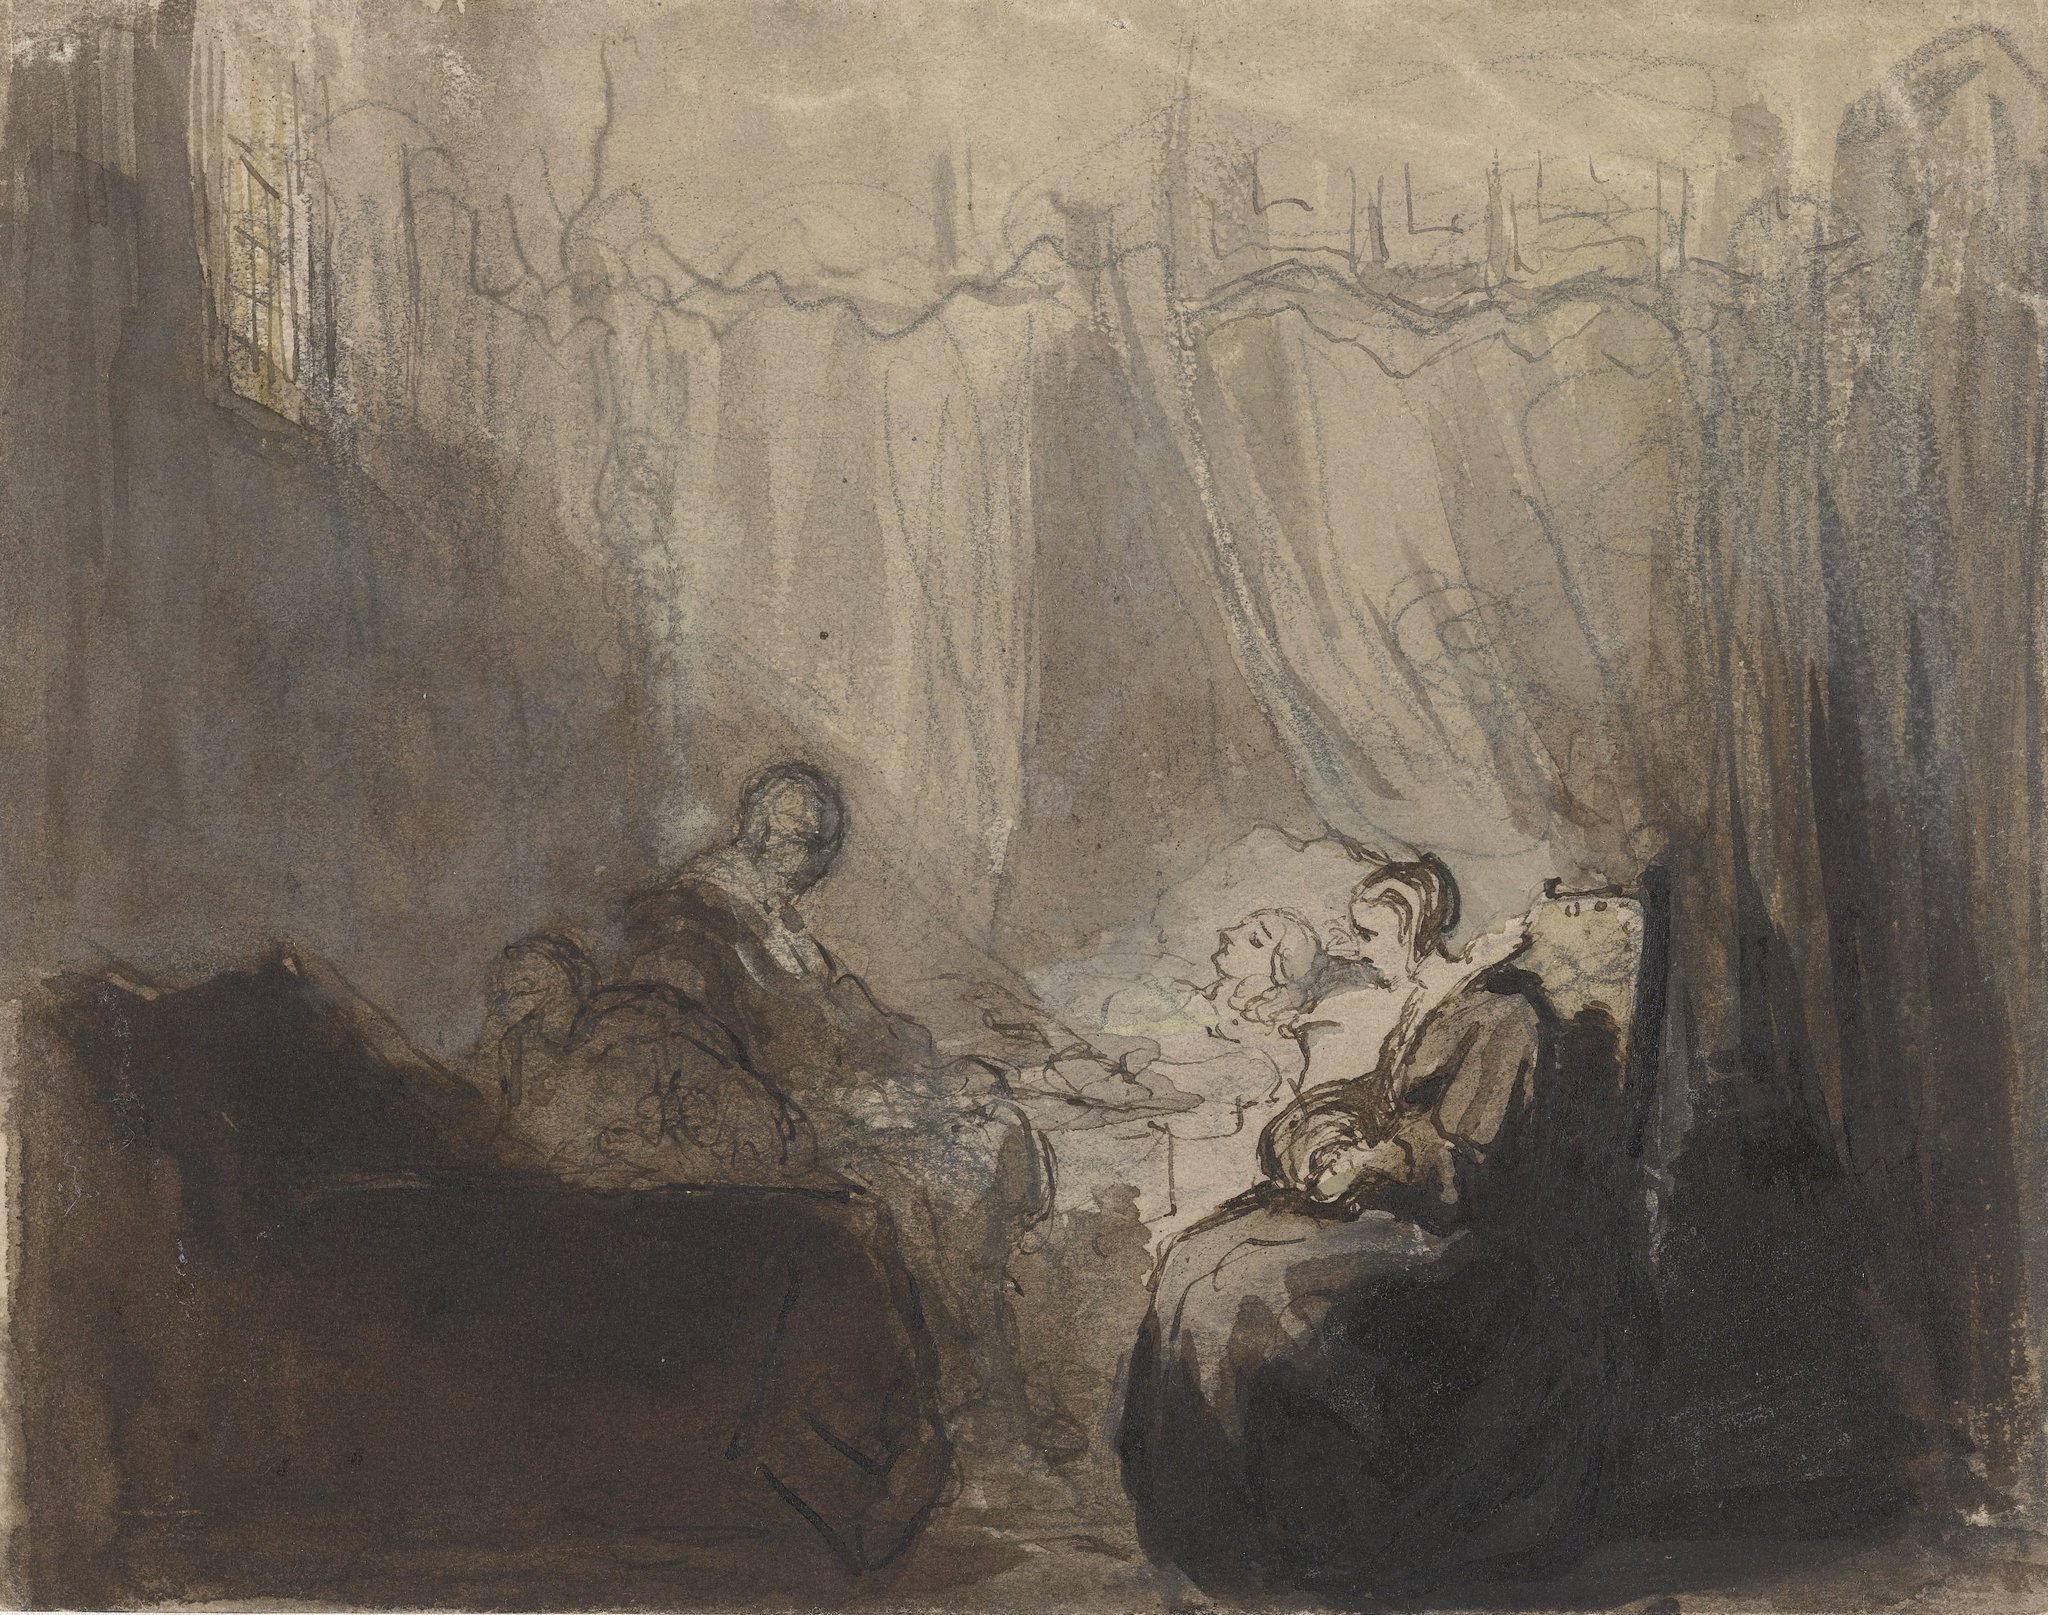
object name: drawing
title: Een ziekbed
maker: christoffel bisschop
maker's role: draughtsman, print maker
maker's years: 1828-1904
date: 1838-1898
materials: ink, paper, pencil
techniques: brush, pen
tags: sick-bed, bedroom